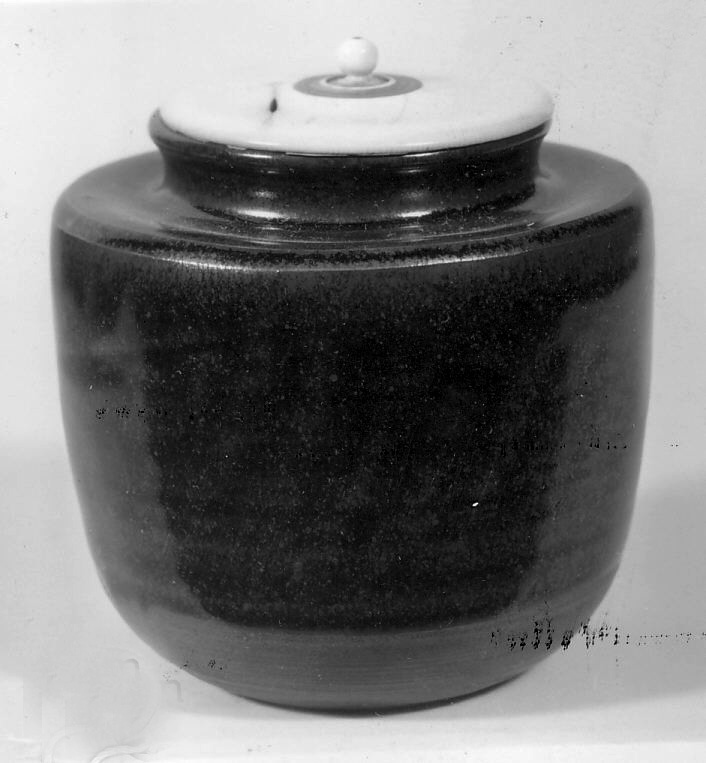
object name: tea jar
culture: japanese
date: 1701-1800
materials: clay, glaze